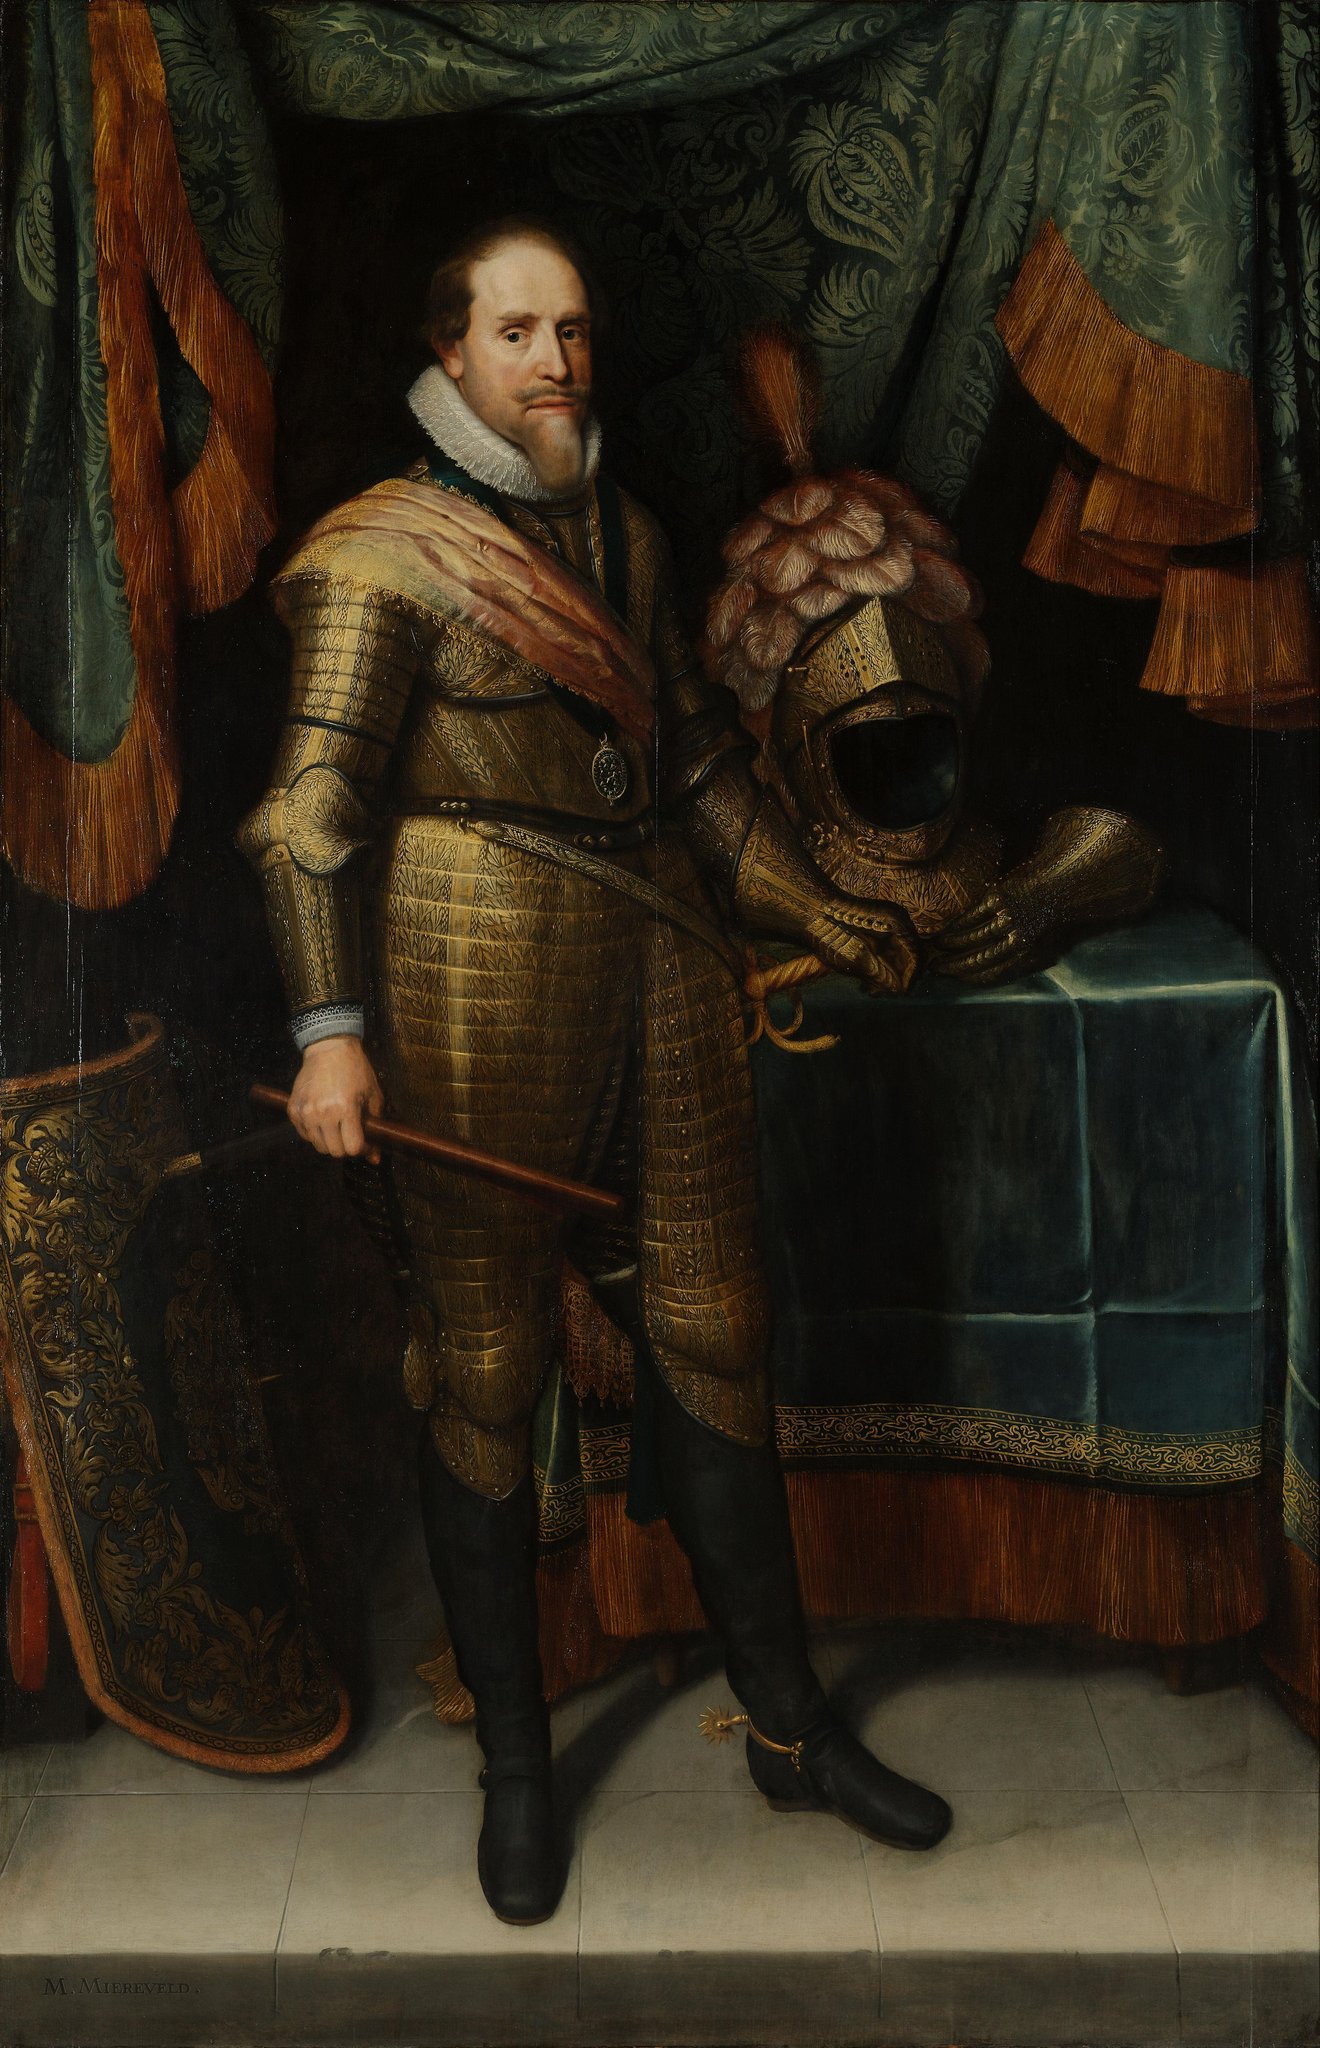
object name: painting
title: Portrait of Maurits (1567-1625), Prince of Orange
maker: michiel jansz van mierevelt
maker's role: draughtsman, painter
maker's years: 1567-1641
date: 1613-1620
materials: oil, panel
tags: maurice (prince of orange), commander-in-chief, general, marshal, armour, historical persons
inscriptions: signature, bottom left: ‘M. Miereveld’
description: Prince Maurits was stadholder and military commander of the Republic of the Seven United Netherlands. He sired eight children with six different mistresses. As he refused to marry he had no legal successor. Maurits stands proud in a ceremonial gilded suit of armour, his helmet and gloves are on the table. This design had been the norm for state portraits since 1551, when it was first devised by the Italian painter Titian.